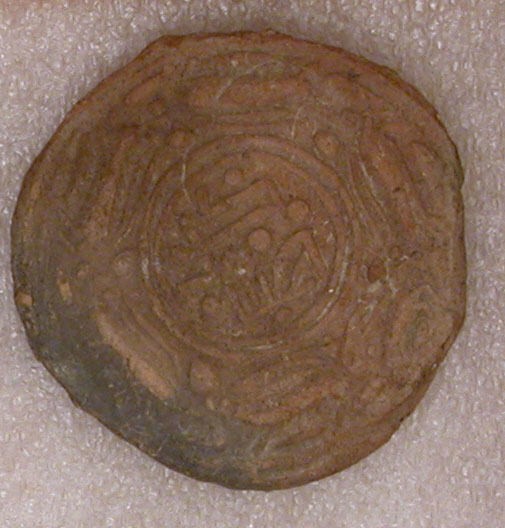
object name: seal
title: Bread Seal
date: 901-1000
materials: earthenware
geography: egypt